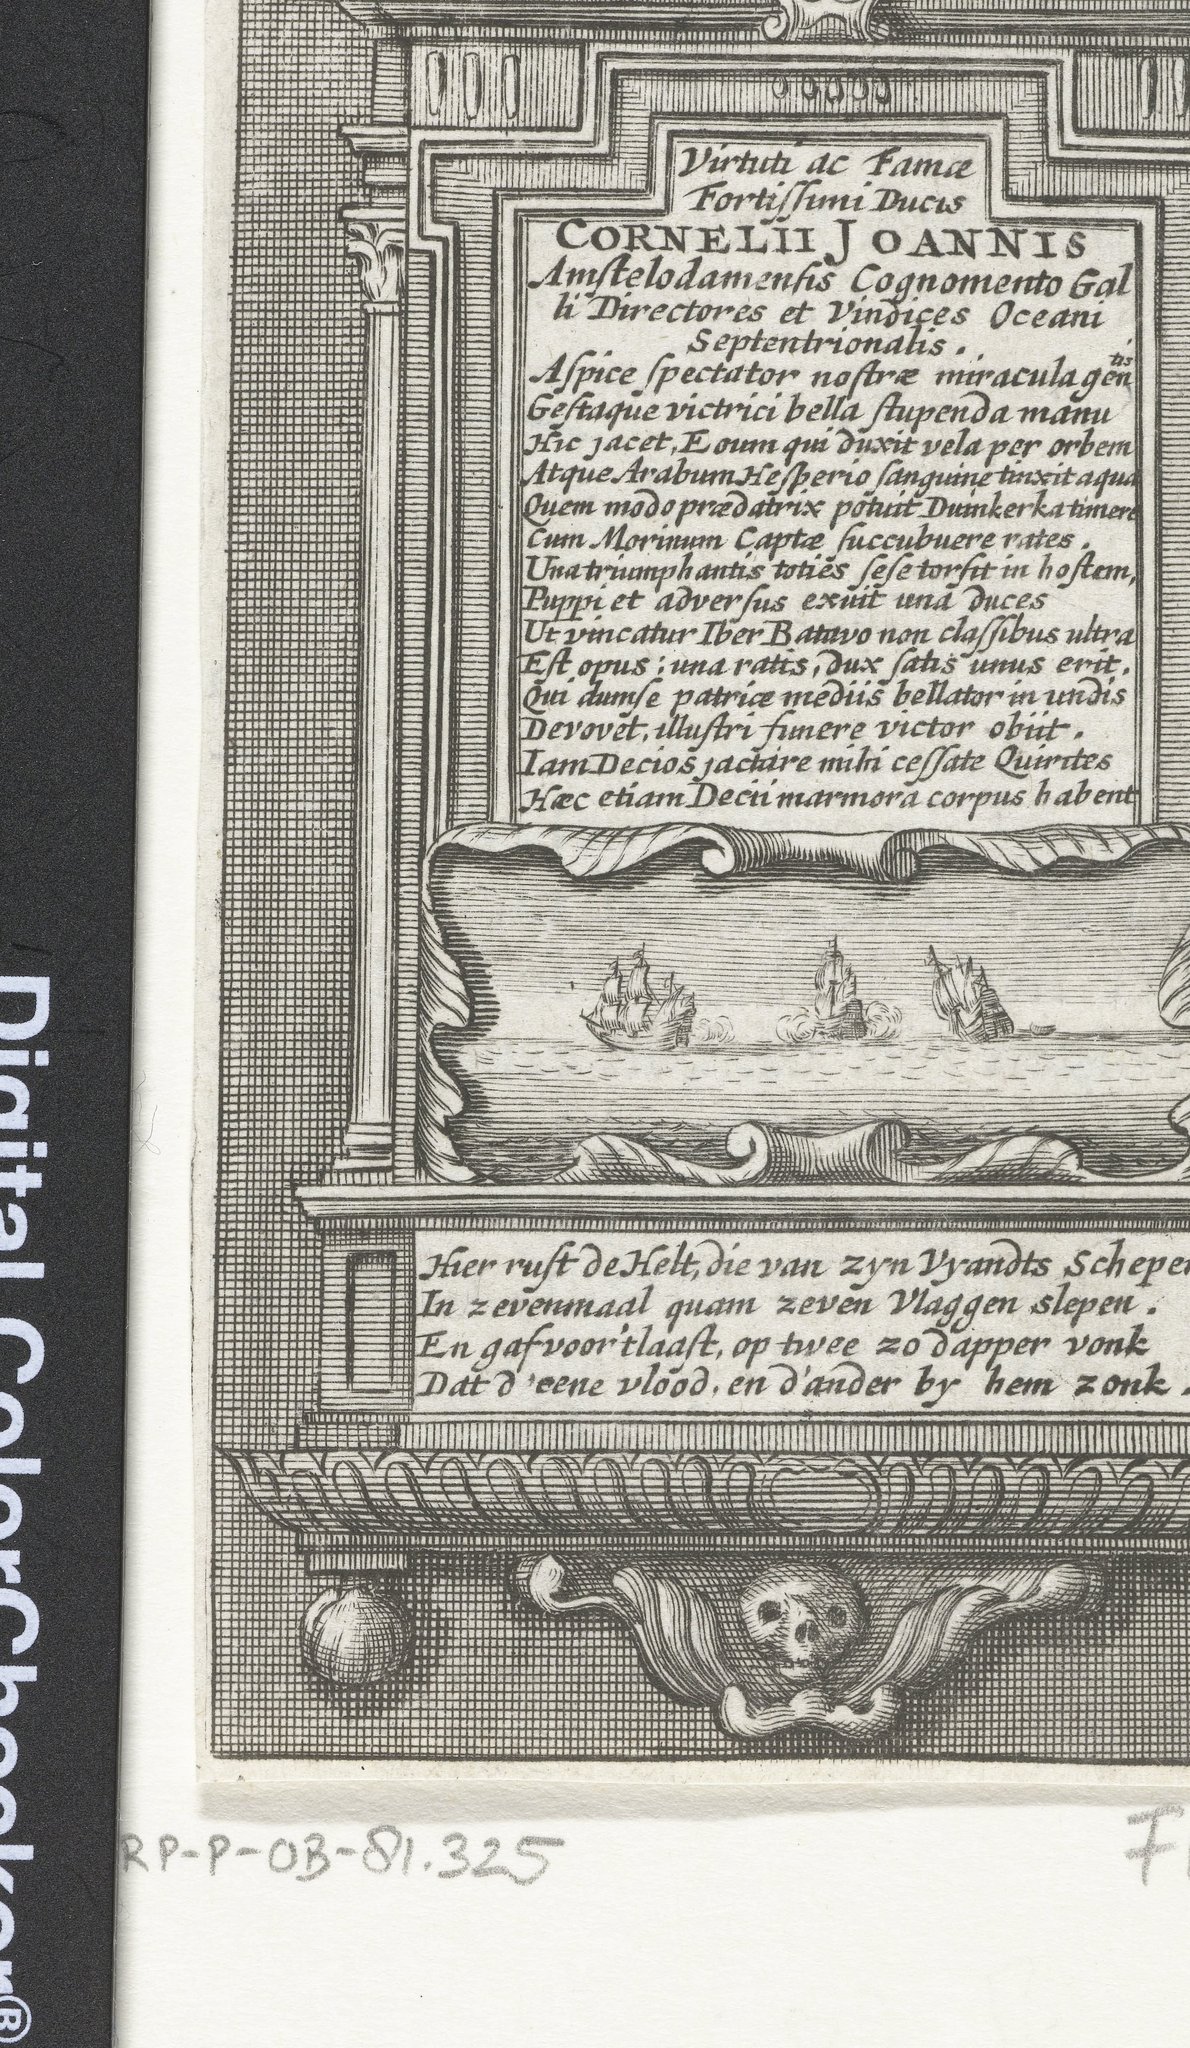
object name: historical object representation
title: Graf van Capeteyn C. Jansz Haen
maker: Anonymous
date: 1633-1699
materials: paper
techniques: engraving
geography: northern netherlands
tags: grave-building, monumental tomb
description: Prent uit: Commelin, Caspar. Beschryvinge van Amsterdam, zynde een naukeurige verhandelinge van desselfs eerste oorspronk uyt (…). Amsterdam: Damme, Andries van, Ratelband, Johannes (II), Aeltwijk, Antony van (wed.), Uytwerf, Hermannus, Goeree, Willem (II) en Goeree, David, 1726, p. 433. Eerdere staat van prent gebruikt in een uitgave uit 1694, p. 433.